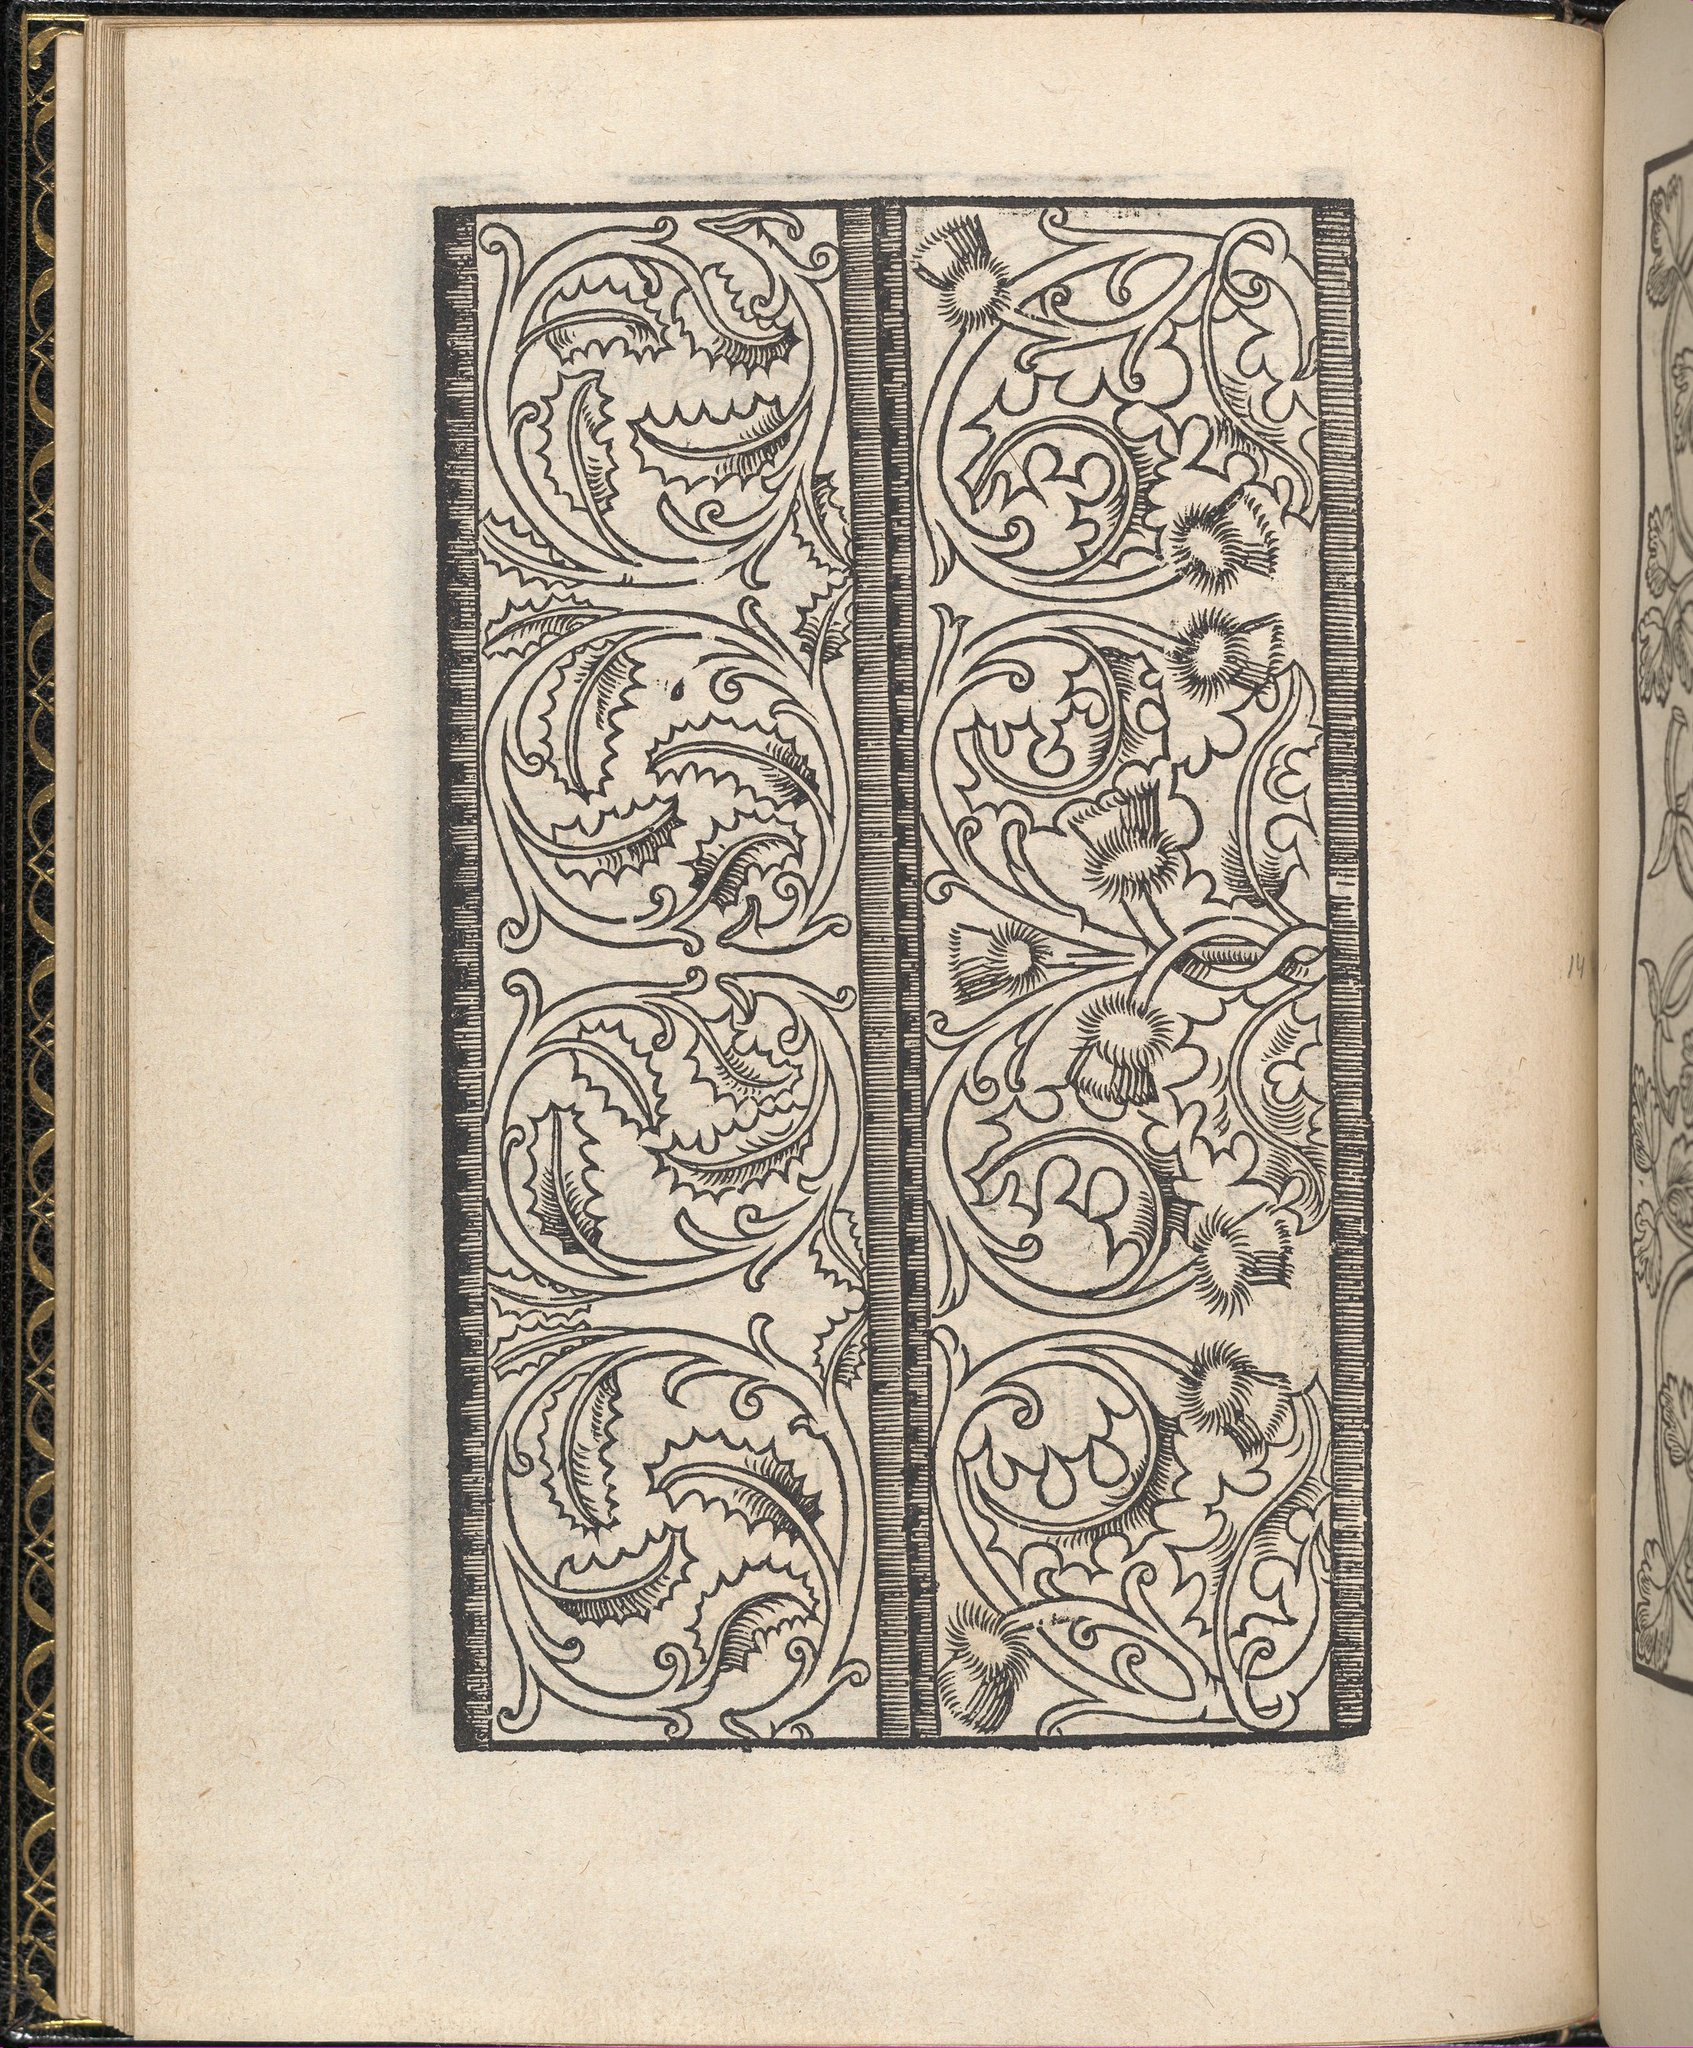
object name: book print ornament architecture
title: Page from Ein new kunstlich Modelbuch...(Page 14v)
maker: peter quentel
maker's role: publisher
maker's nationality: german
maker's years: 1500-1550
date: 1544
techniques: woodcut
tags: flowers